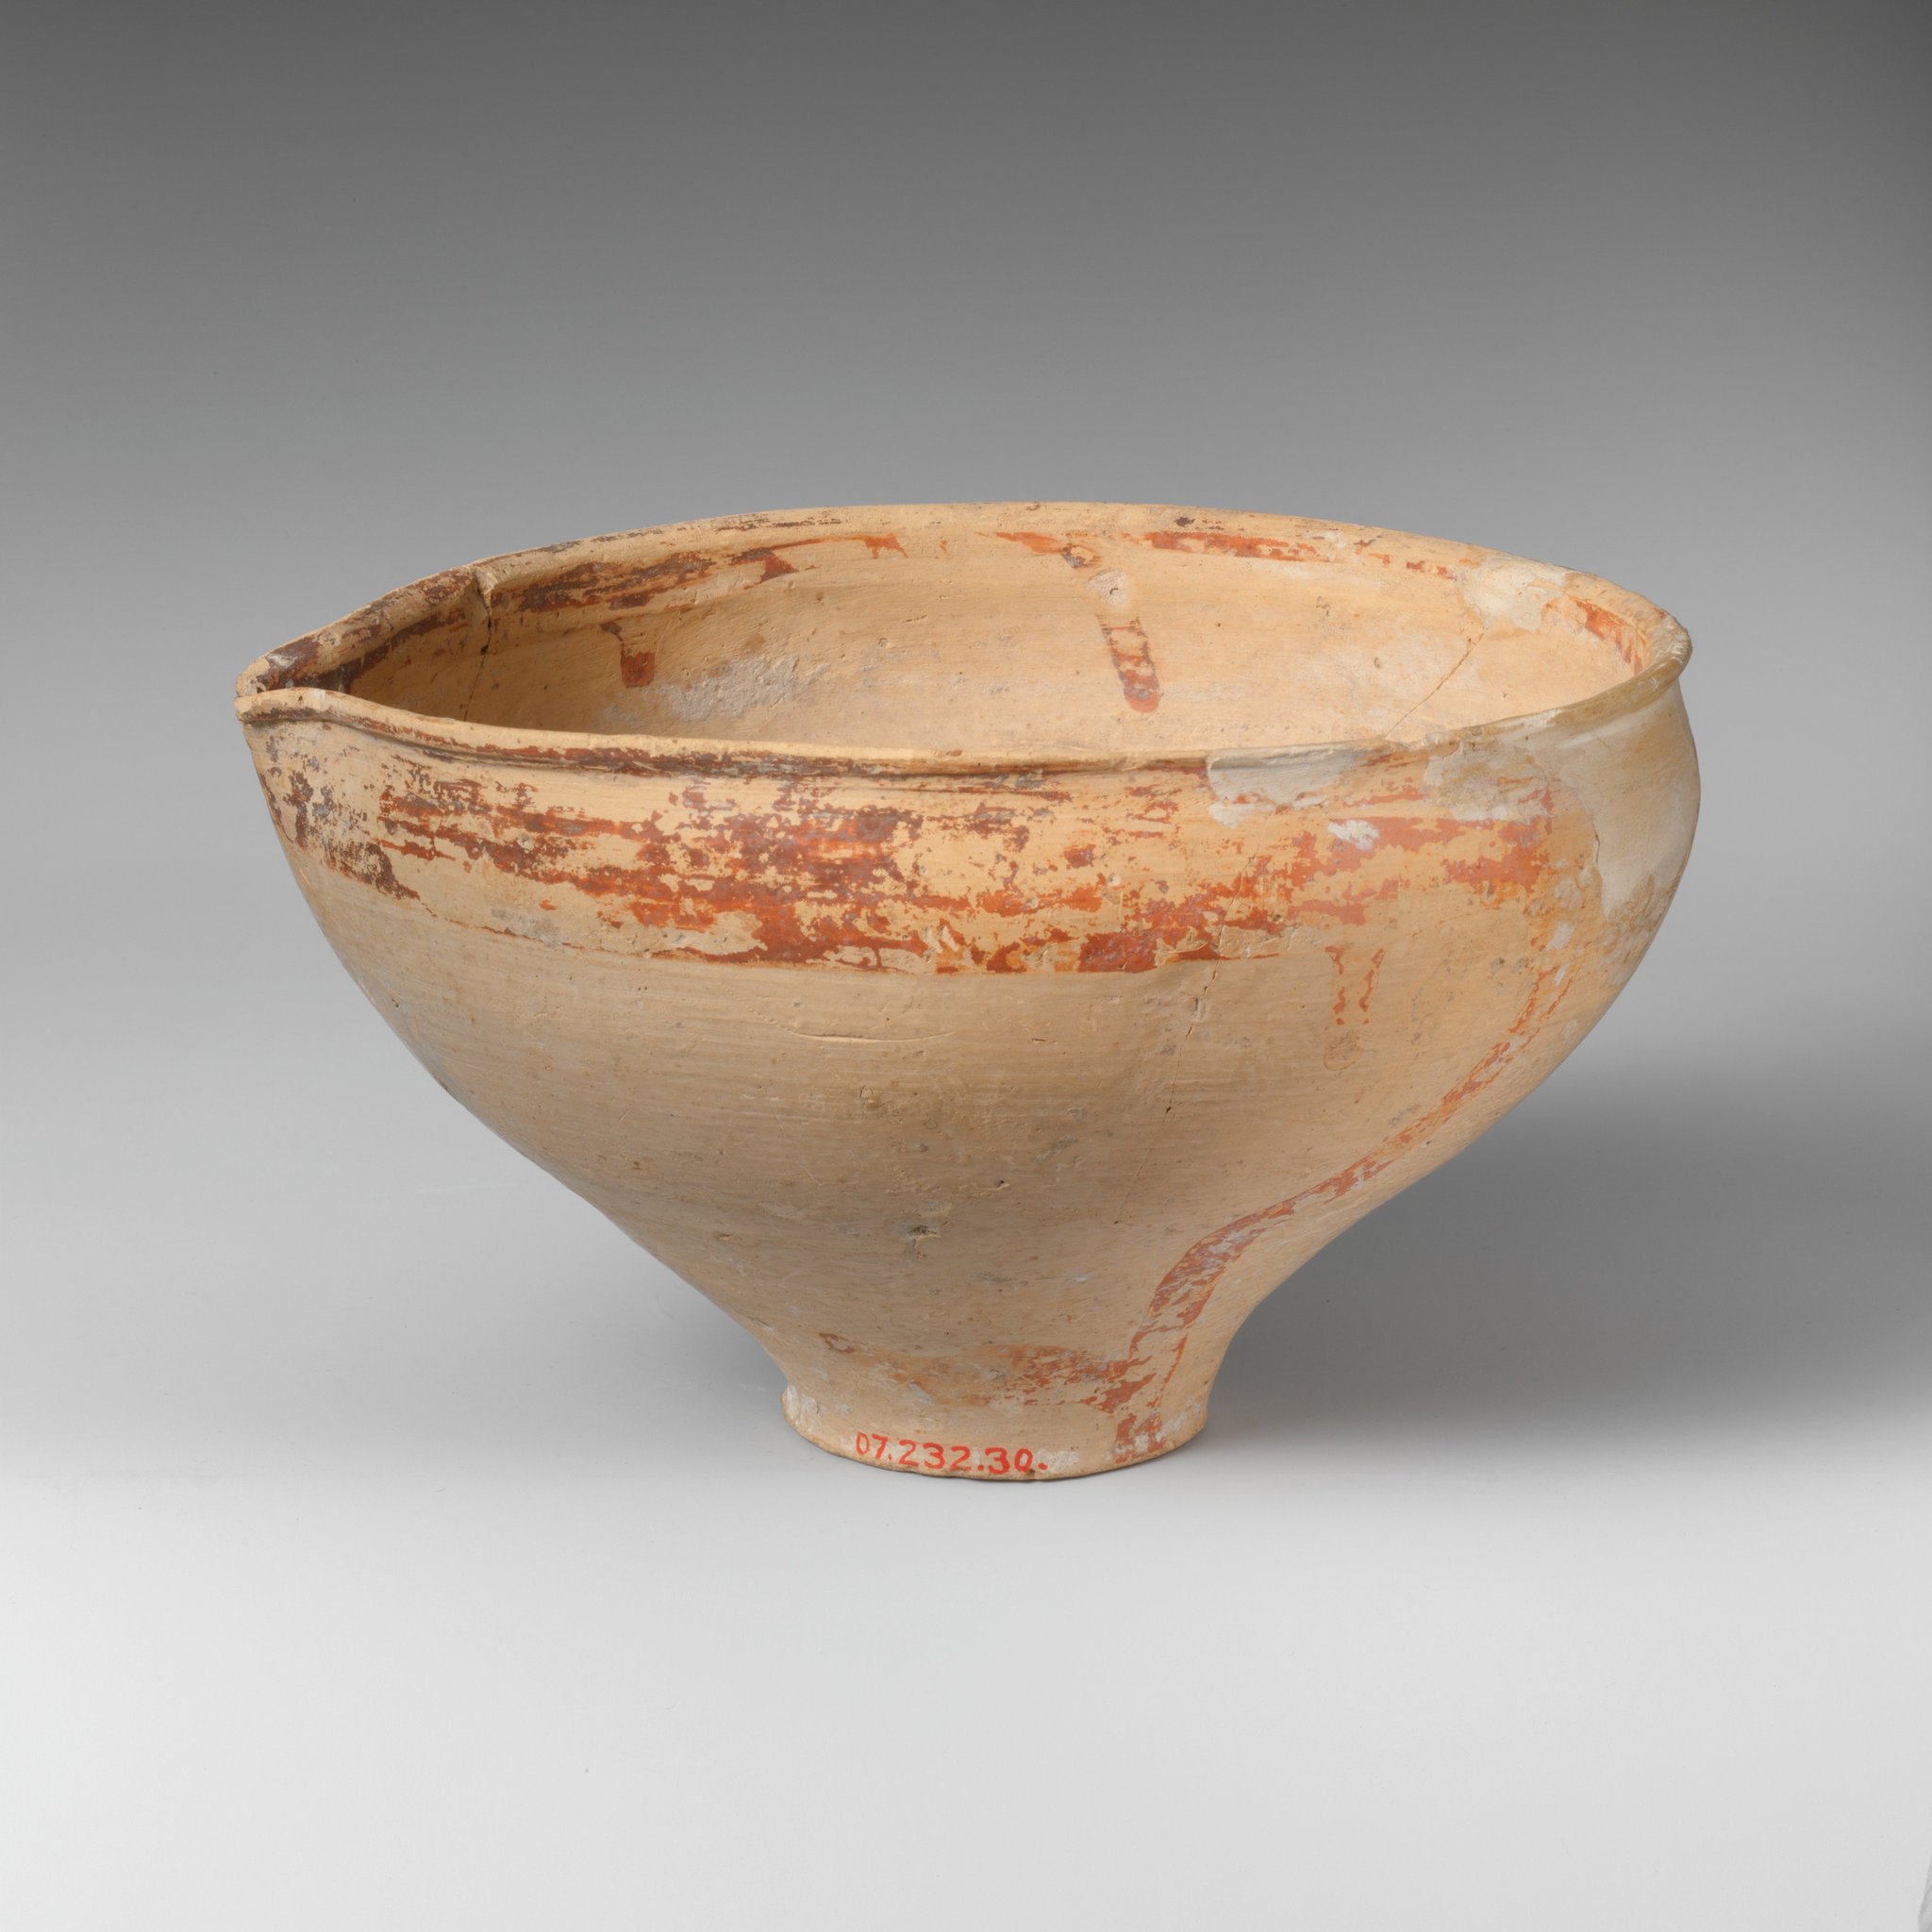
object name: cup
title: Terracotta pulled rim bowl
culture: minoan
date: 1400-1200 BCE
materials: terracotta